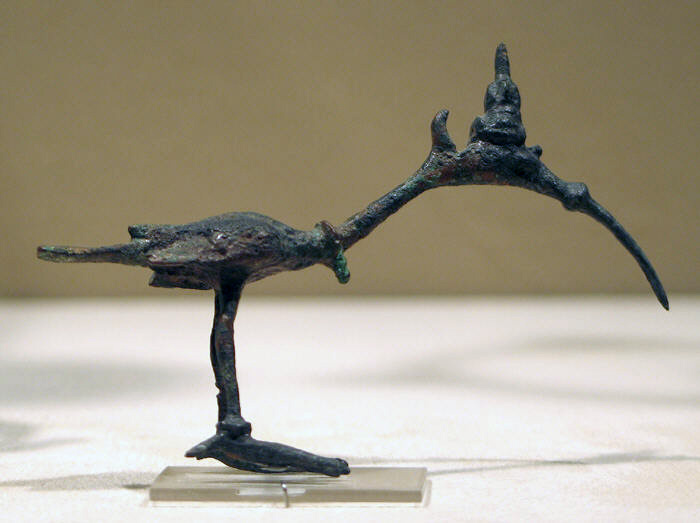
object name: bird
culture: indonesian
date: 500 BCE-300 CE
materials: bronze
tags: birds